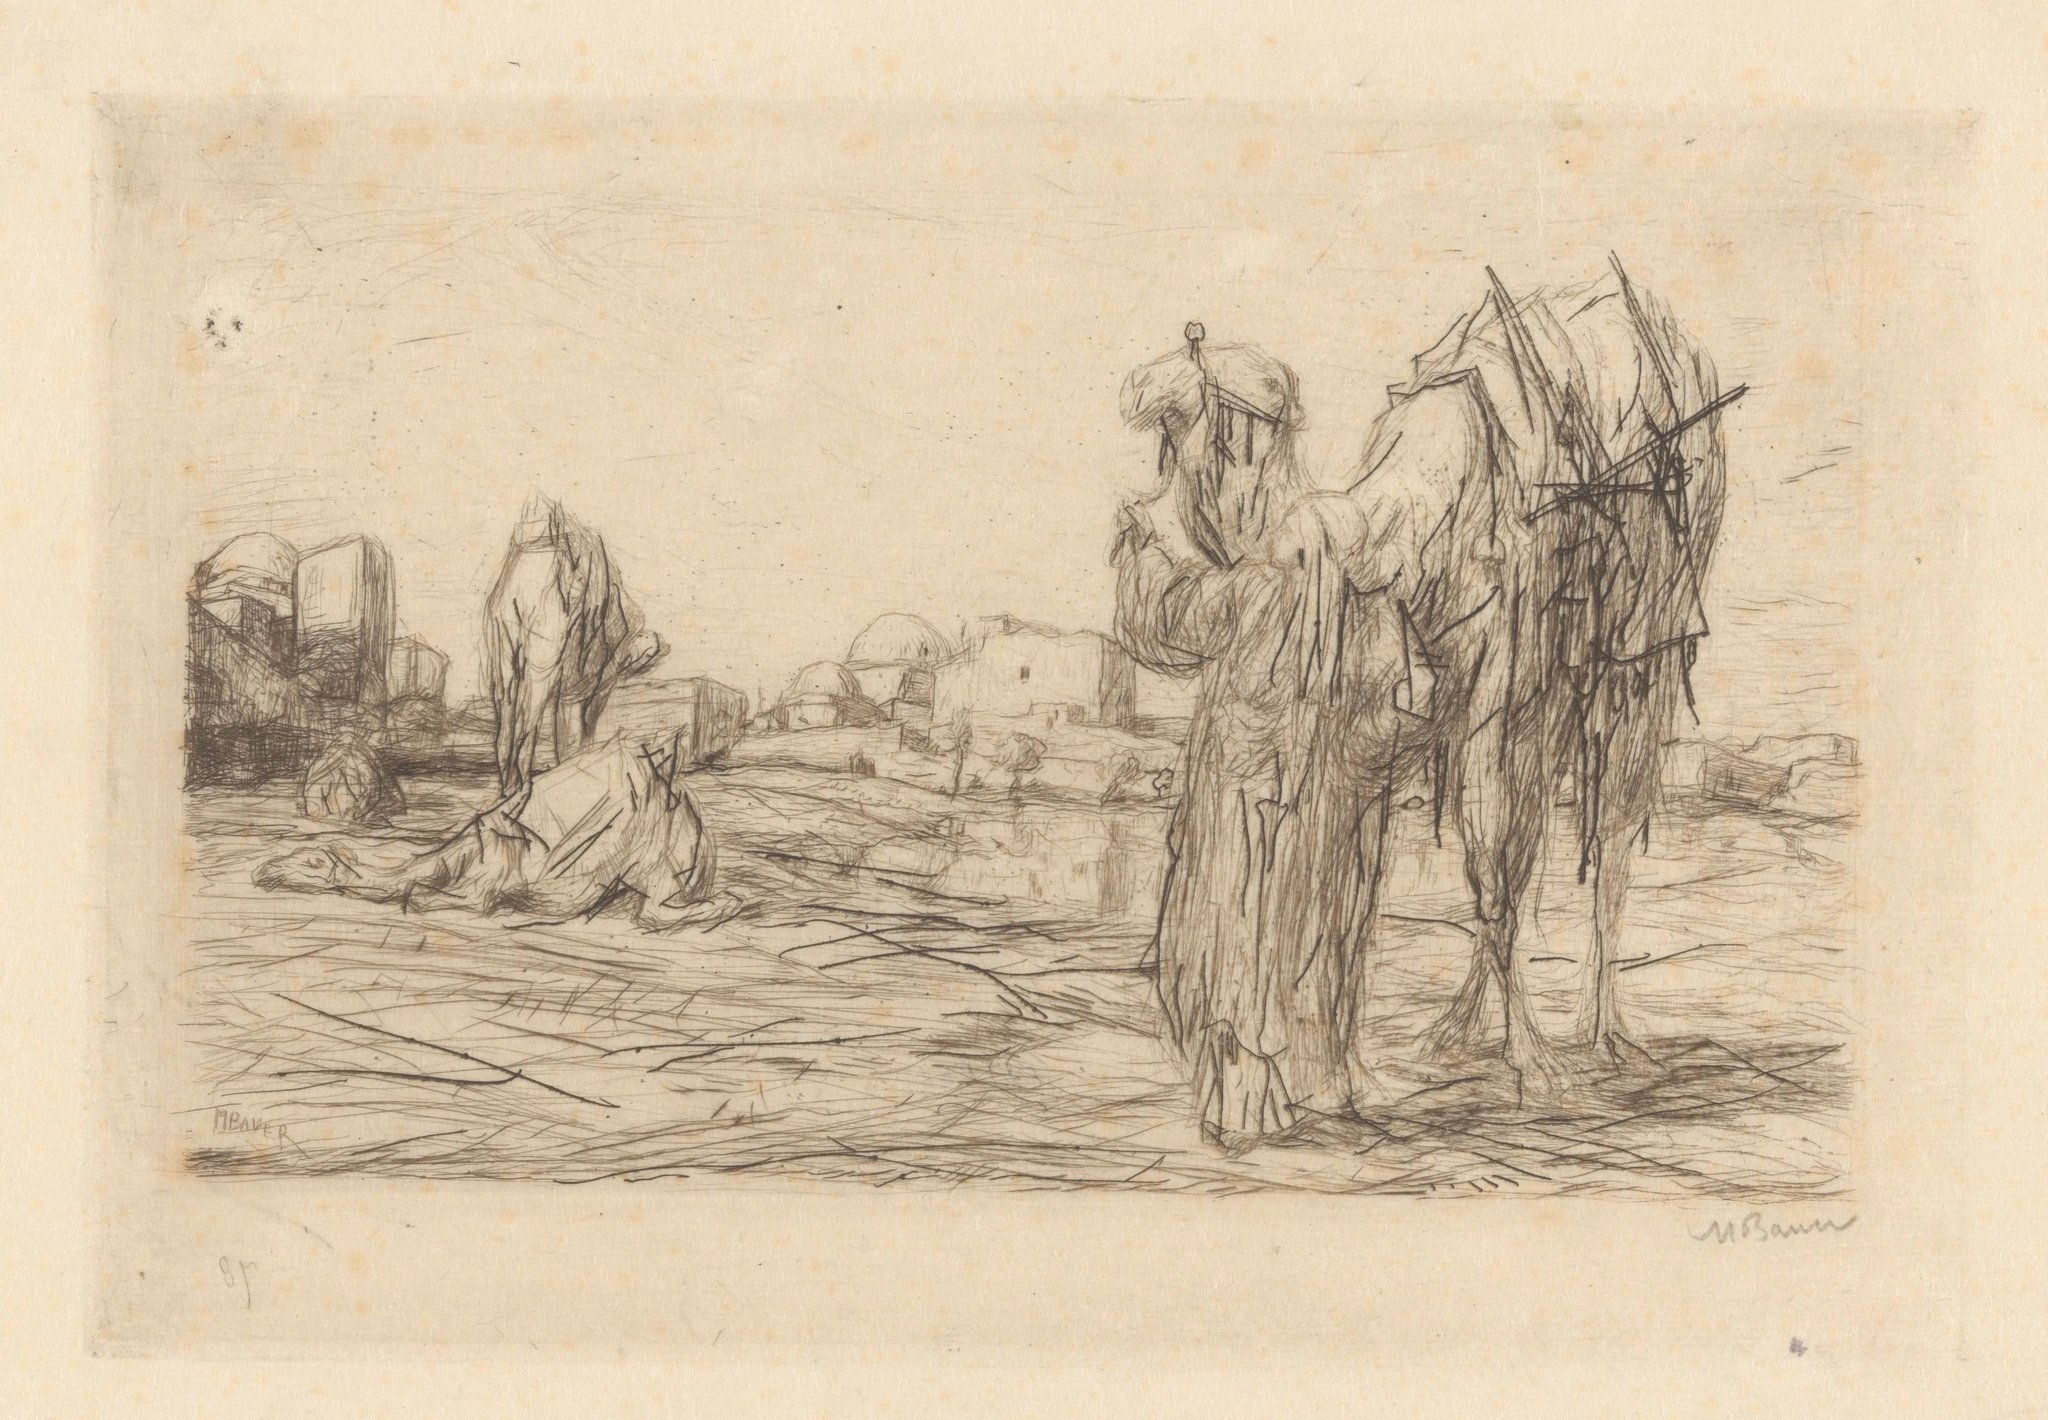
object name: print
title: Kamelen met drijver voor een stad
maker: marius bauer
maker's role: draughtsman, print maker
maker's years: 1867-1932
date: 1877-1932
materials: paper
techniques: etching, intaglio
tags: hoofed animals: camel, city-view, and landscape with man-made constructions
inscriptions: collector's mark: Lugt 2521a, collector's mark: Lugt 2228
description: Een man houdt een kameel aan zijn tuig vast. Links nog drie kamelen. Op de achtergrond een stad met verschillende gebouwen met koepels.